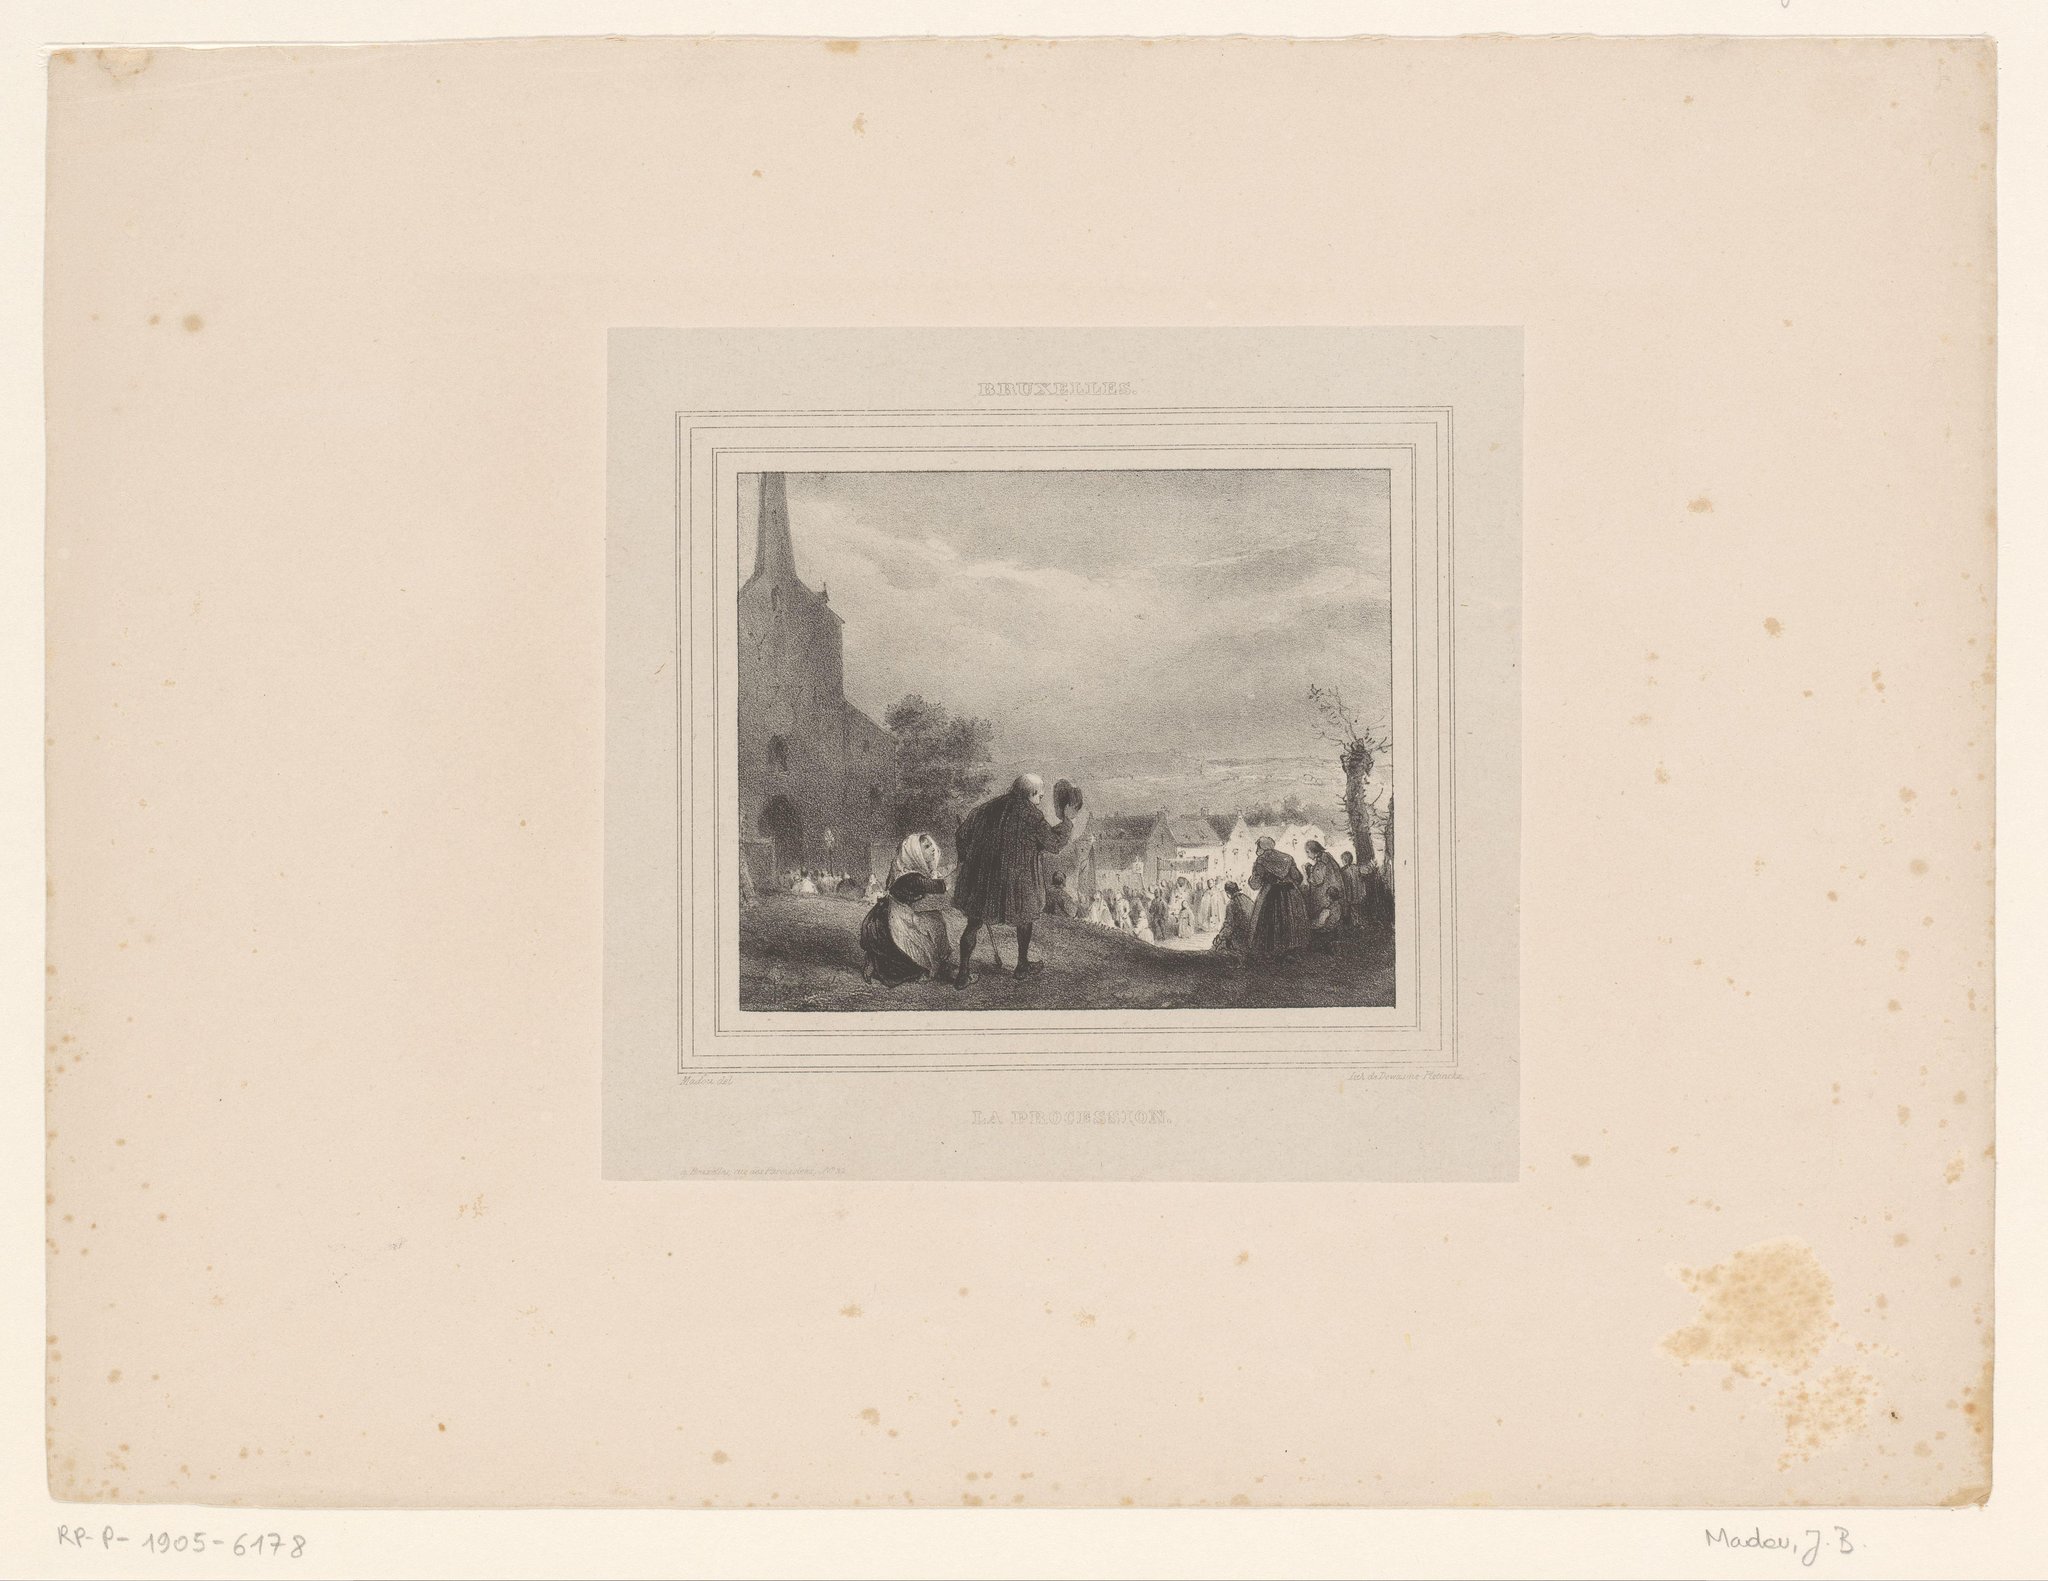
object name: print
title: La procession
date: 1831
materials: paper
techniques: lithograph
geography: brussels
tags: baring the head, lifting one's hat, church (exterior), procession ~ christian religion, brussels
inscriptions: collector's mark: Lugt 2228